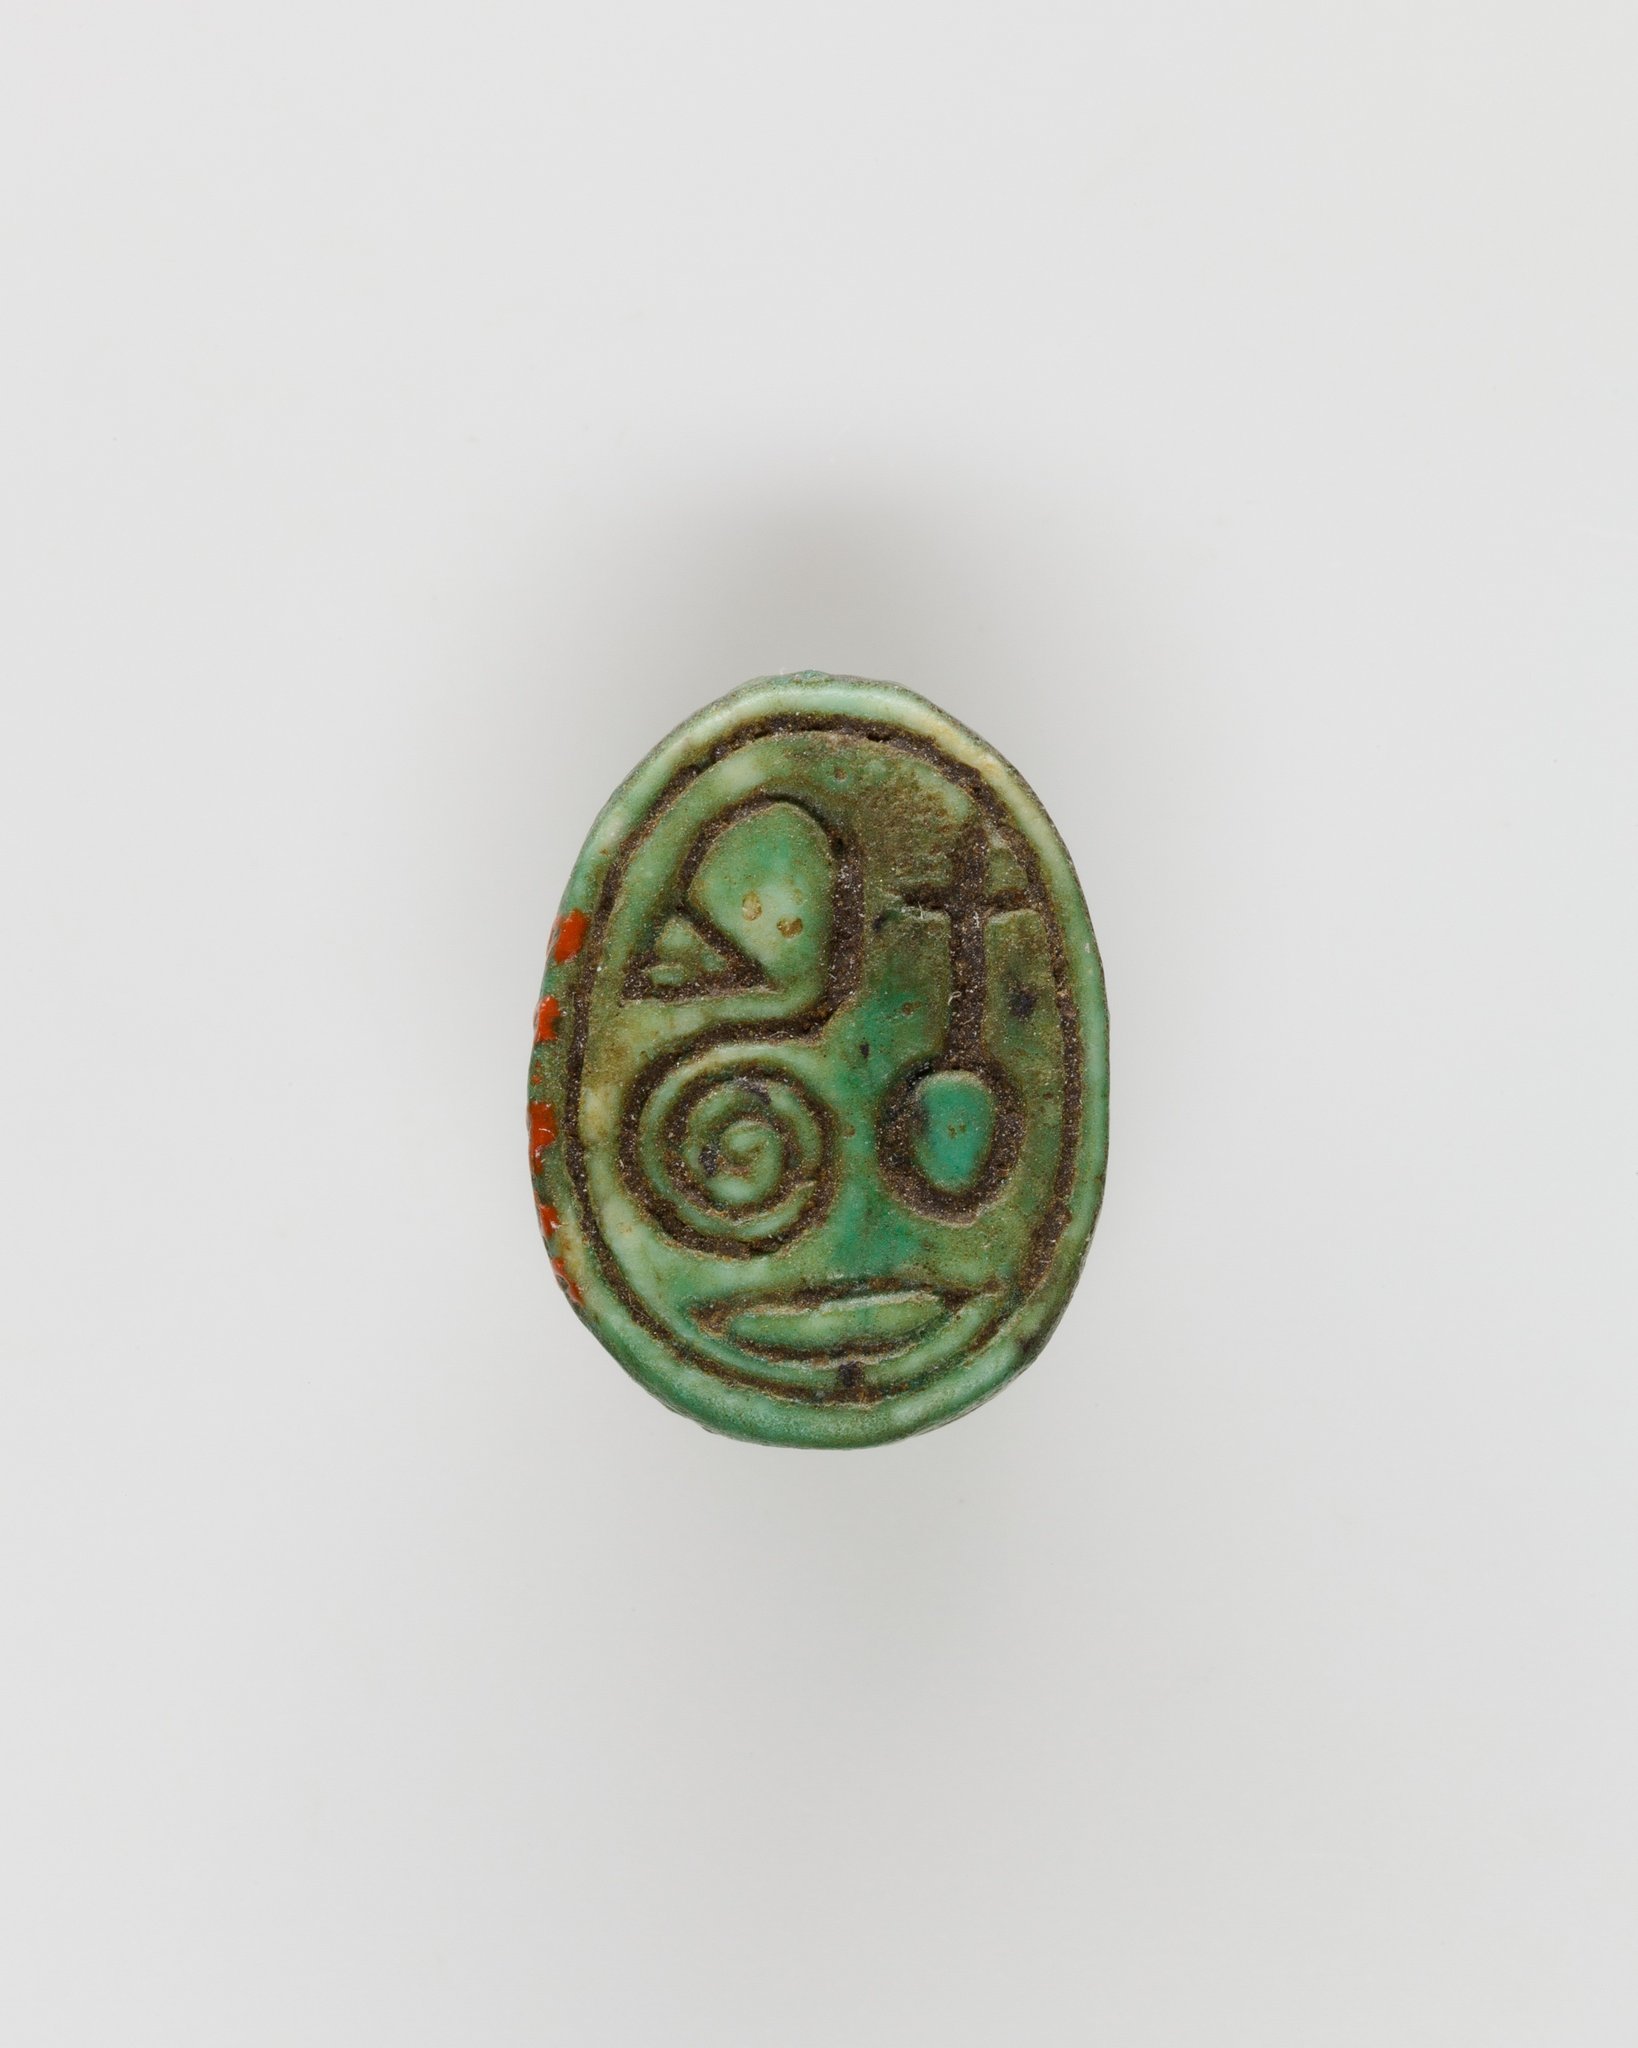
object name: scarab, nefer, lotus, spiral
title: Scarabs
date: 1492-1473 BCE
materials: stone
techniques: glazing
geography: egypt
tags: hieroglyphs,scarabs